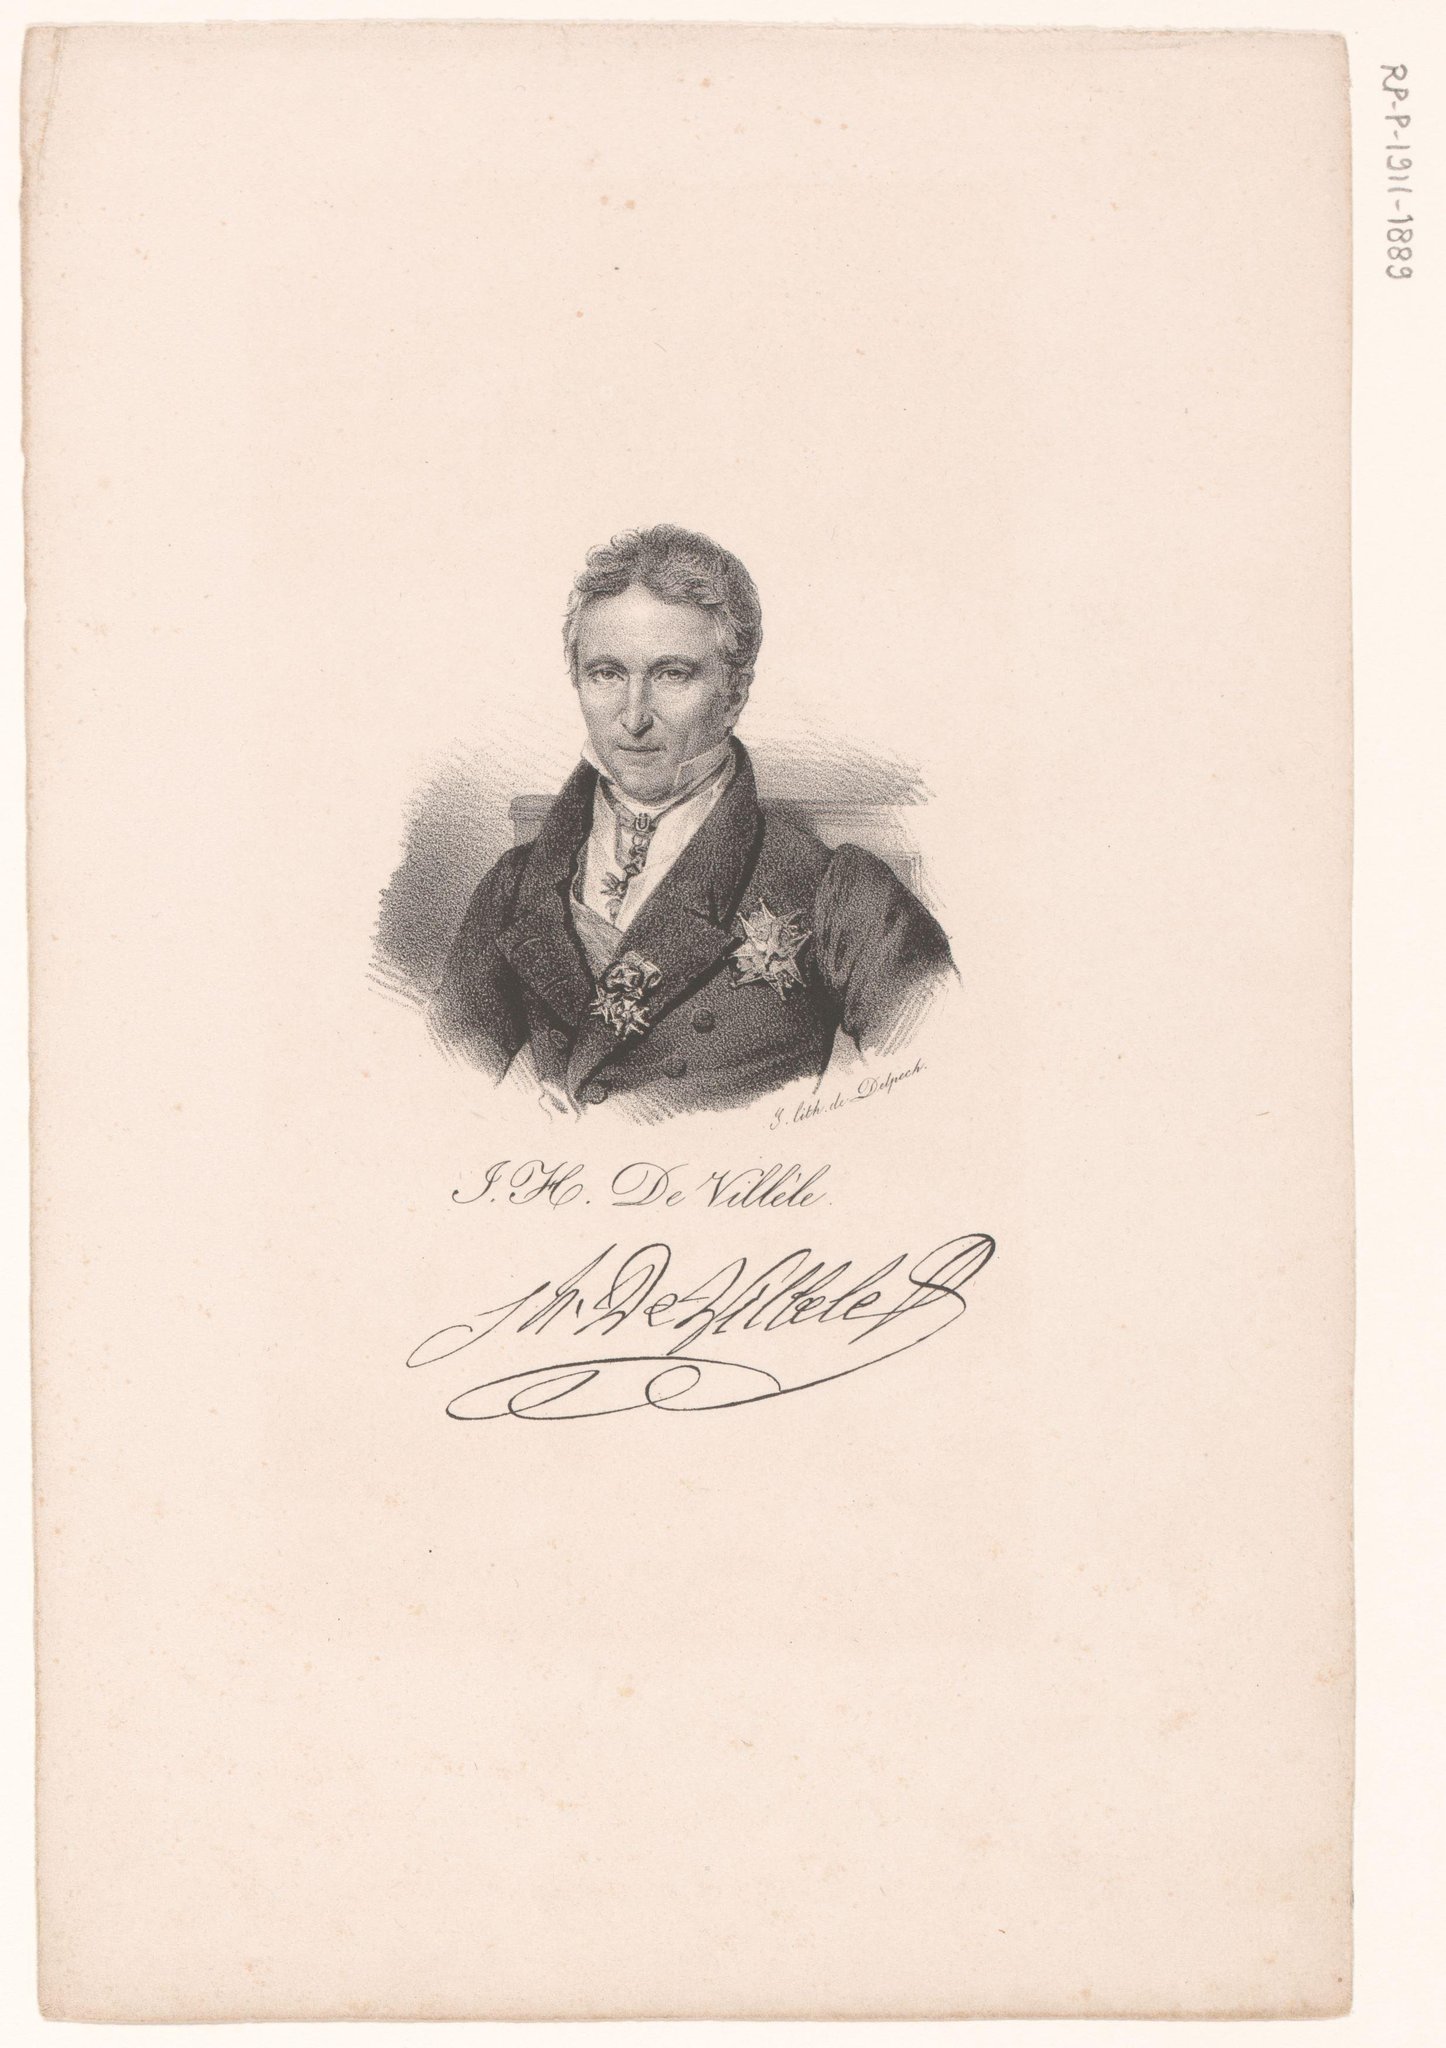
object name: print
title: Portret van Joseph de Villèle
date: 1818-1842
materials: paper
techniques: lithograph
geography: paris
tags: politician, mayor, historical persons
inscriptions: collector's mark: Lugt 2228a